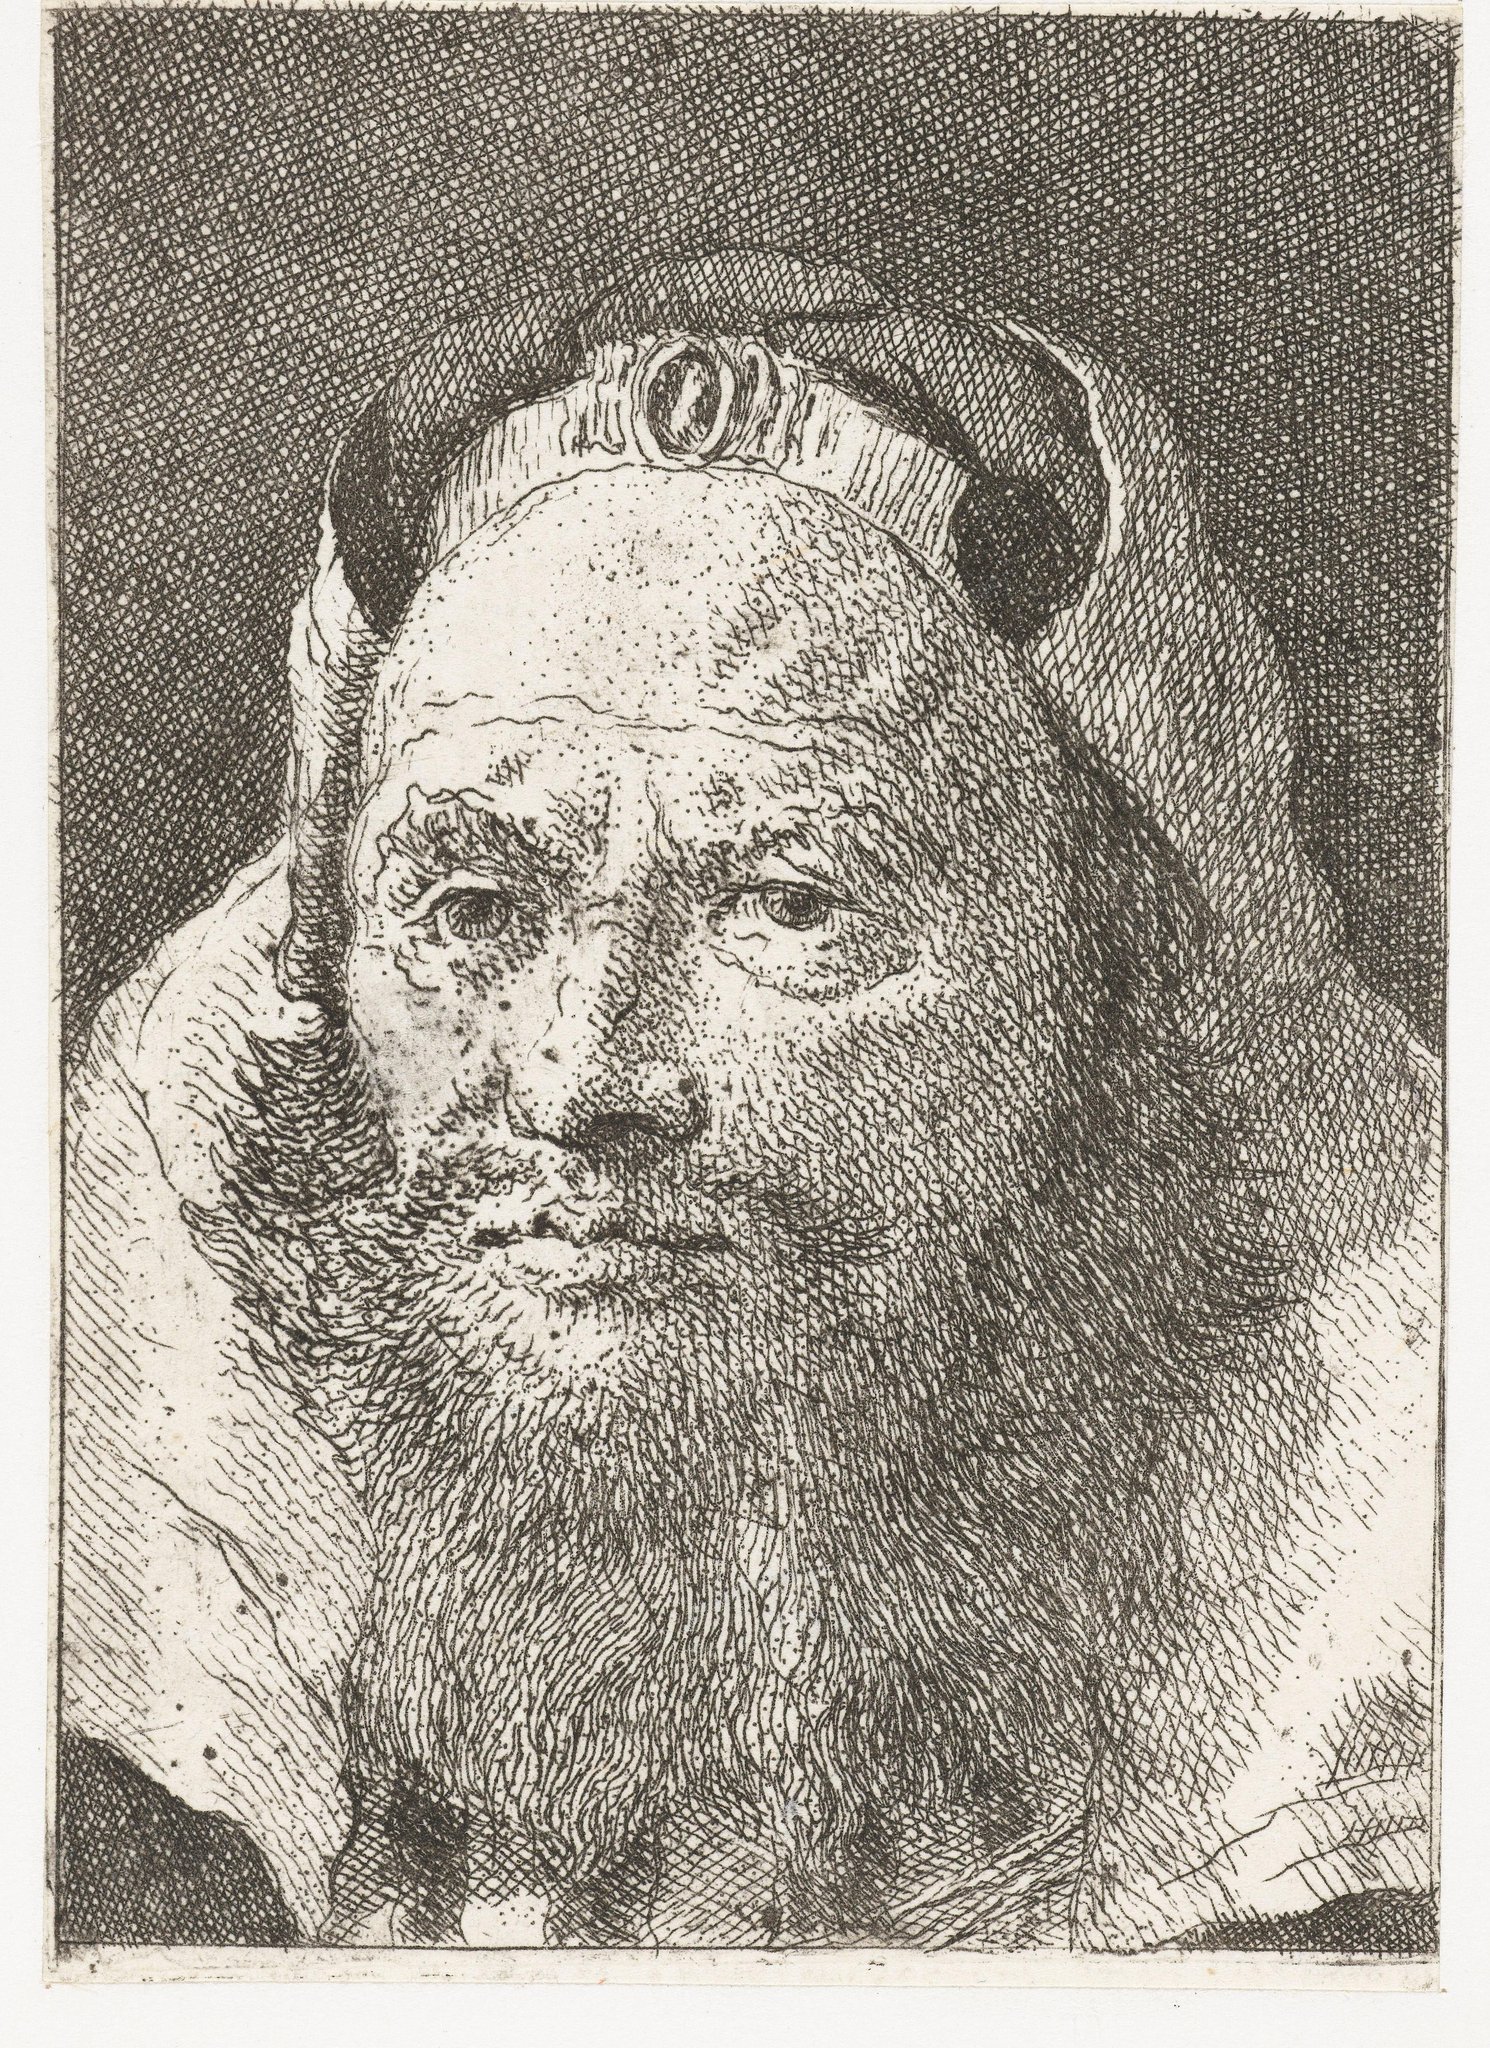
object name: print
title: Raccolta di Teste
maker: giovanni domenico tiepolo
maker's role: draughtsman, print maker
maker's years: 1727-1804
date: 1771-1774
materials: paper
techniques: etching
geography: venice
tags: head-gear: cap (+ men's clothes)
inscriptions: collector's mark: Lugt 2228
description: Prent uit serie Verzameling hoofden (Raccolta di teste). Giovanni Domenico Tiepolo vervaardigde in de winter van 1757-1758 en in de periode van 1771-1774 deze hoofden naar schilderijen en tekeningen van Giovanni Battista Tiepolo. De eerste uitgave verscheen in 1774 in twee delen met elk dertig prenten. Deze prent werd in de tweede staat met serienummer 7 opgenomen in deel 2.